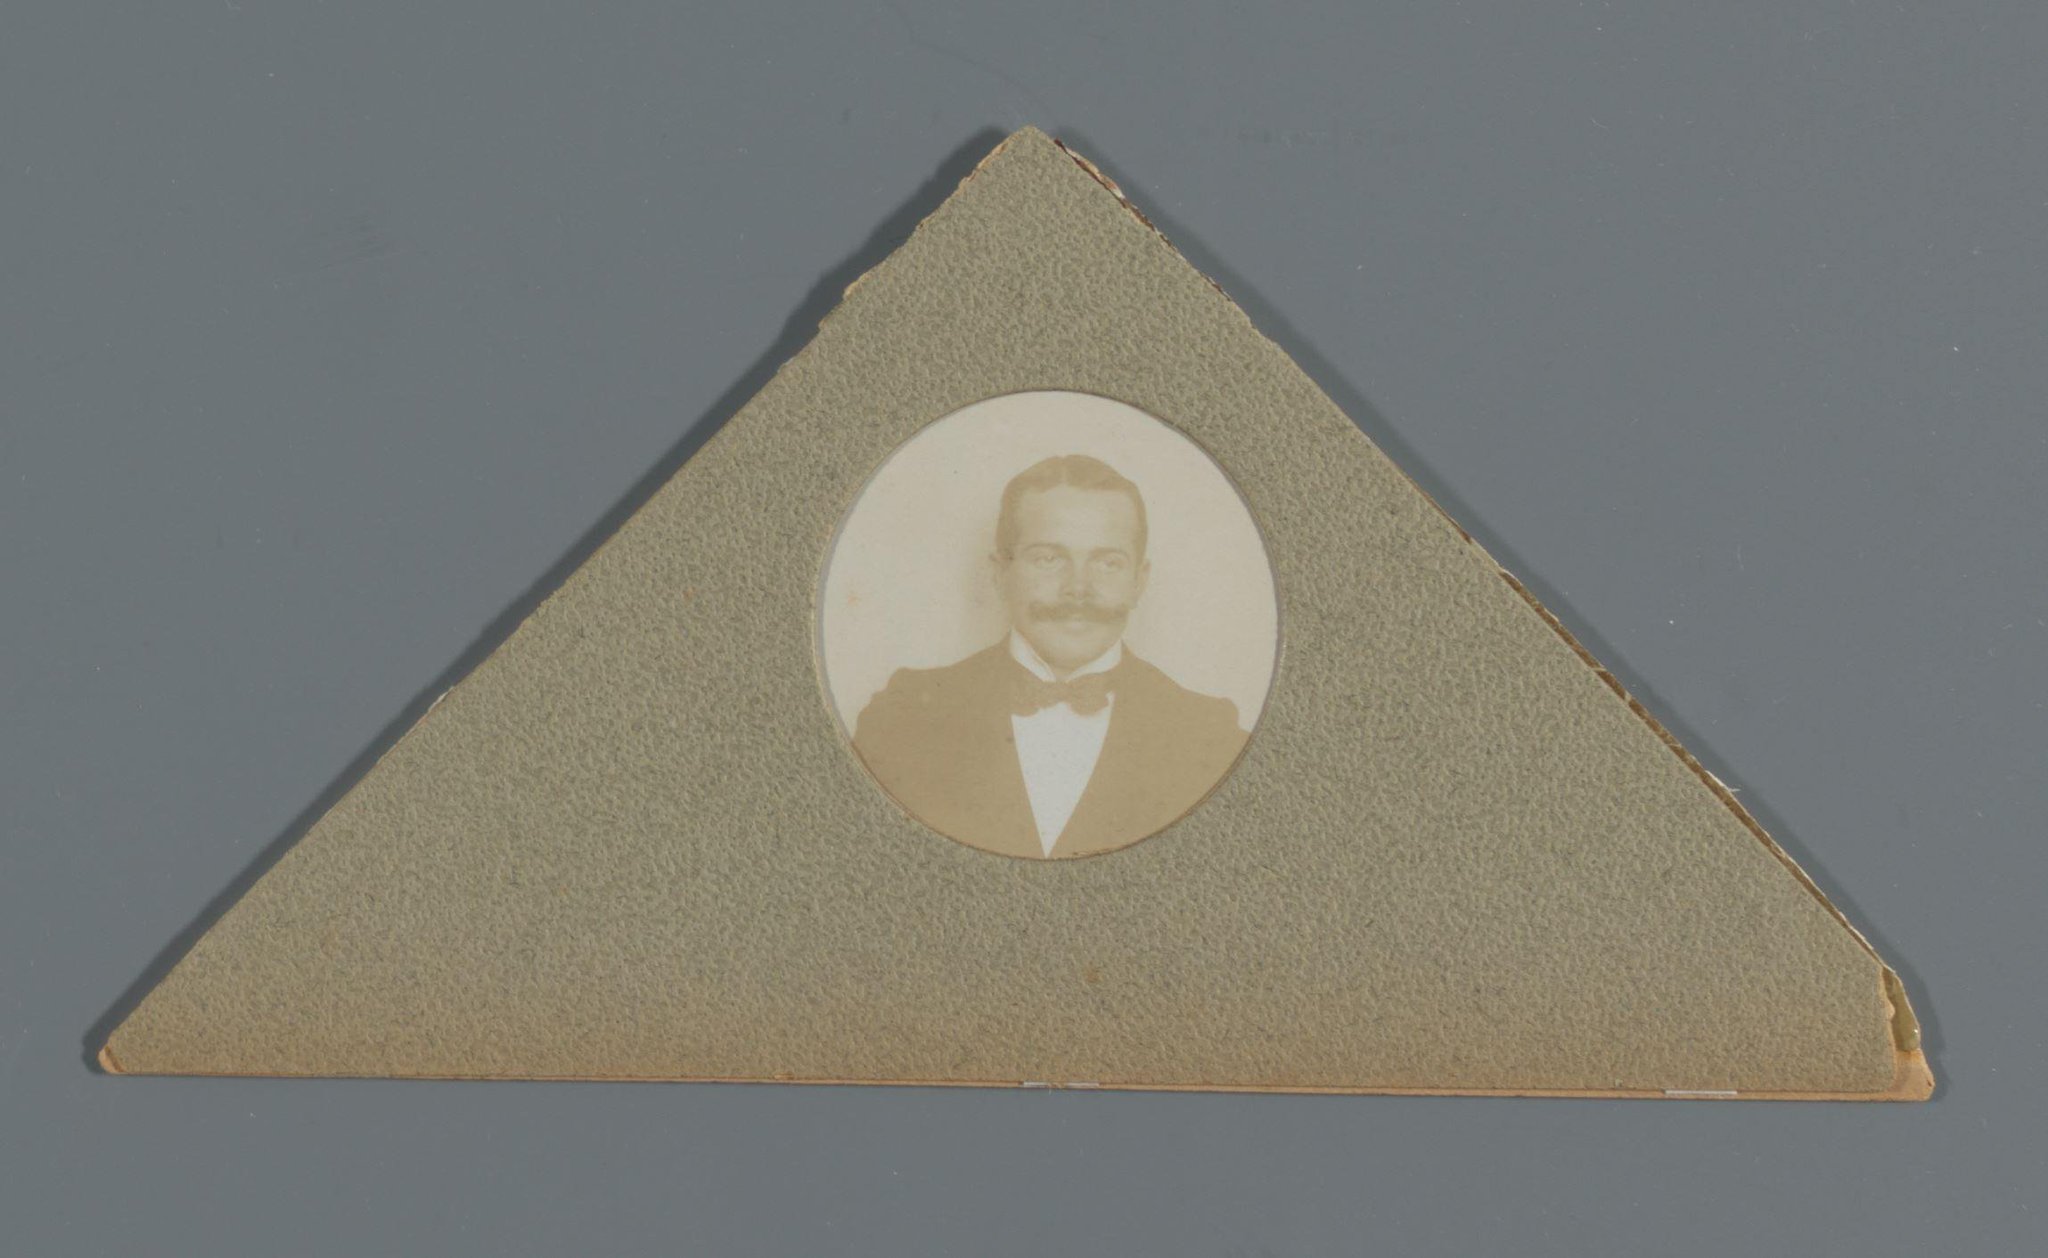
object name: photograph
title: portret van Hendrik Herman van den Berg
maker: hendrik herman van den berg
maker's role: amateurfotograaf, jurist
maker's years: 1875-1944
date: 1896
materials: photographic support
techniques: collodion silver print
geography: amsterdam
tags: rotterdam, amsterdam, norbertus petrus van den berg (1831-1917), historical persons (portraits and scenes from the life)